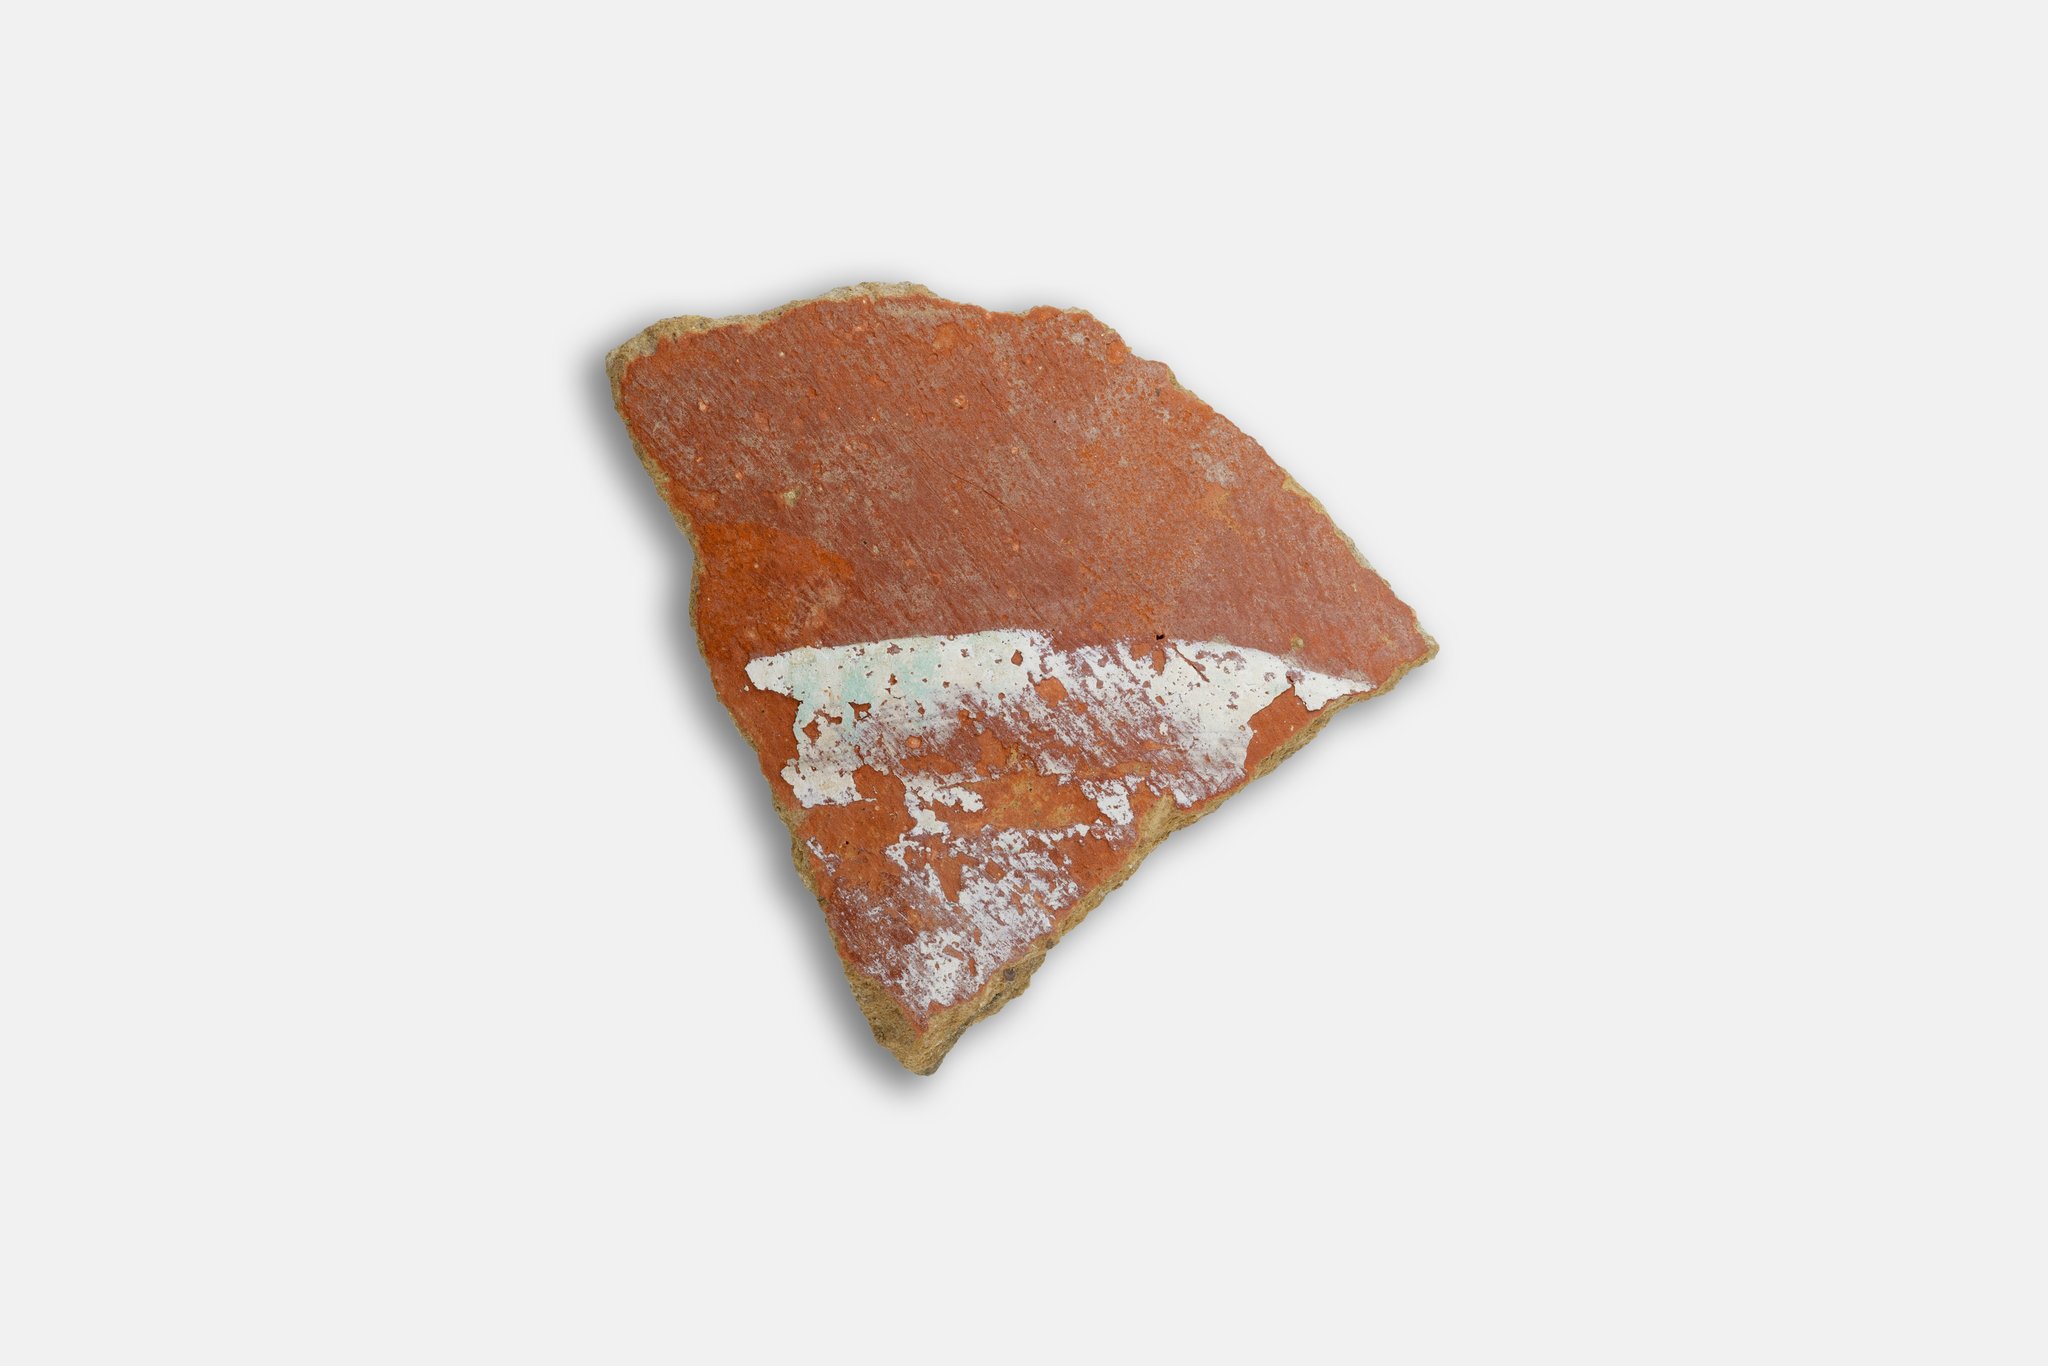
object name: jar fragment, inscribed, malqata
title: Decorated jar fragment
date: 1390-1352 BCE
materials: ink, paint, pottery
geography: egypt